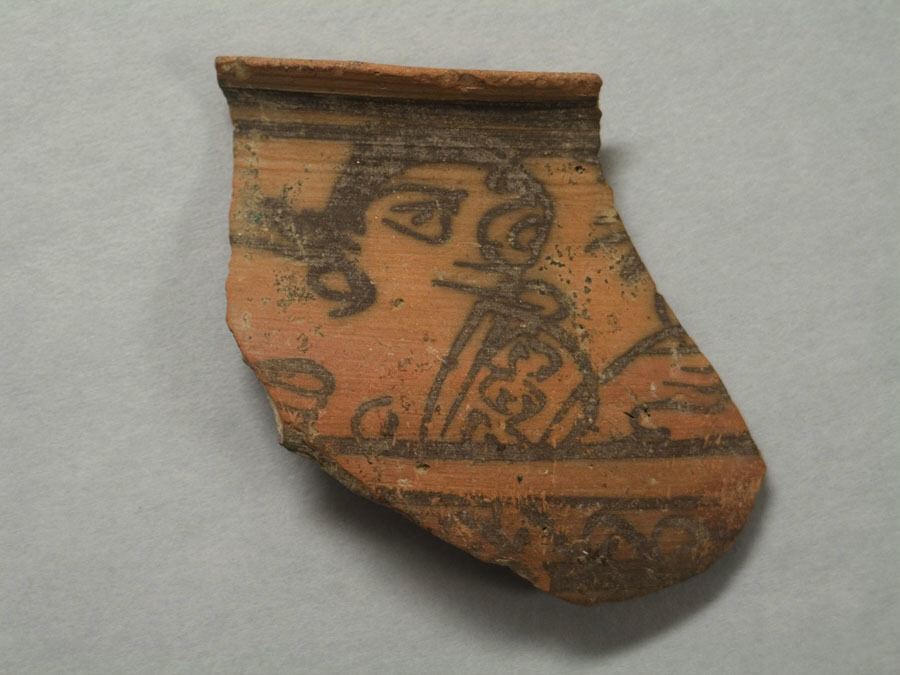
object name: shard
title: Shard: Neckpiece with Head of Offerer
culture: pakistani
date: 301-500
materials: terracotta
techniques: painting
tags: gandhara,heads